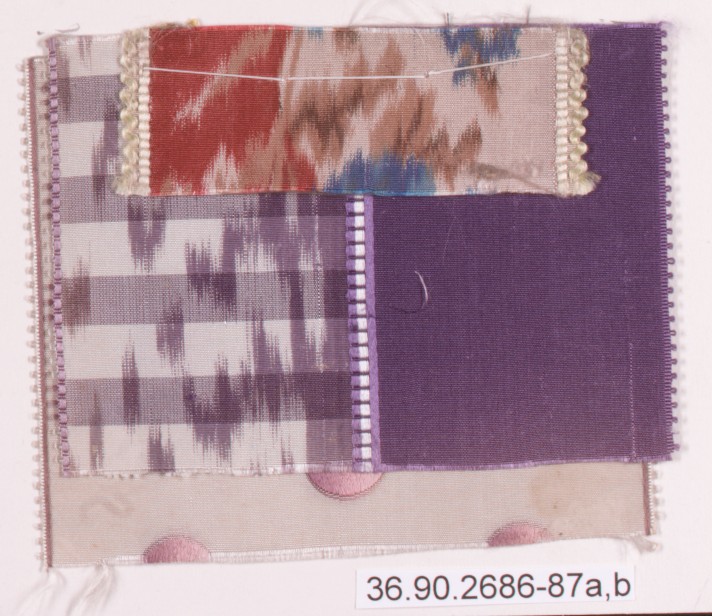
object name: ribbon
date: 1801-1900